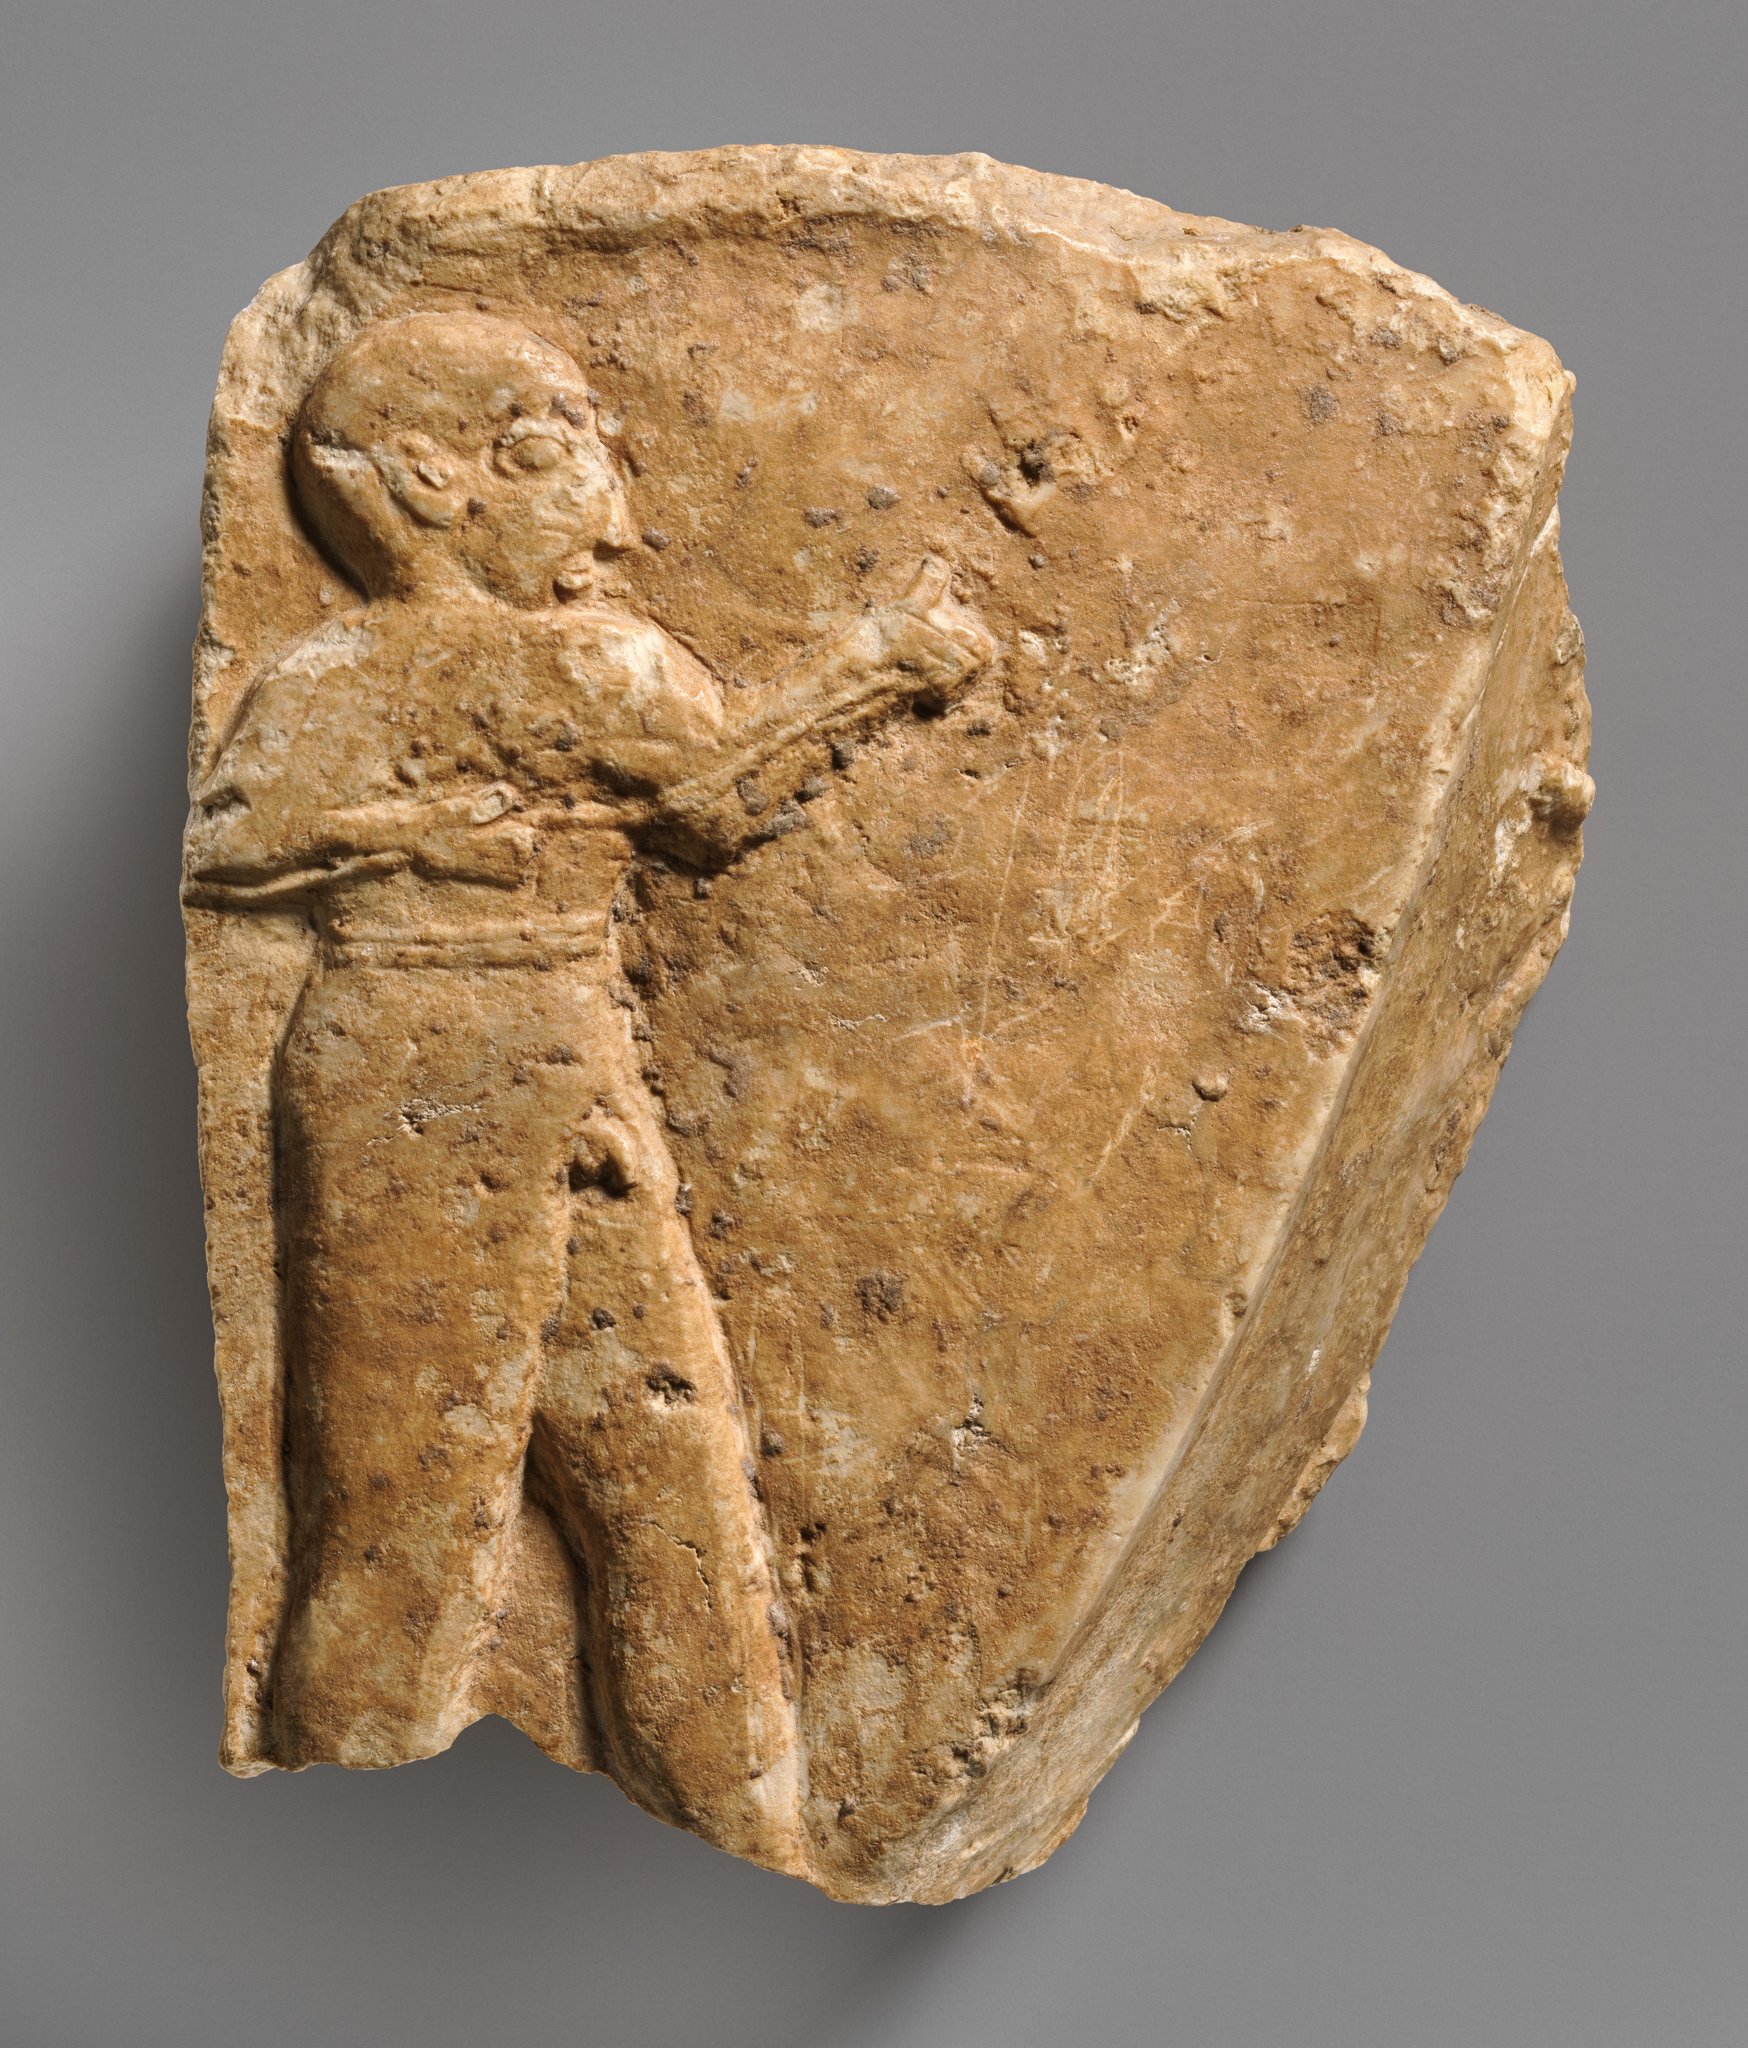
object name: trough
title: Fragment of a trough with a nude male figure in relief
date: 3300-2900 BCE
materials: alabaster, gypsum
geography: southern mesopotamia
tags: male nudes